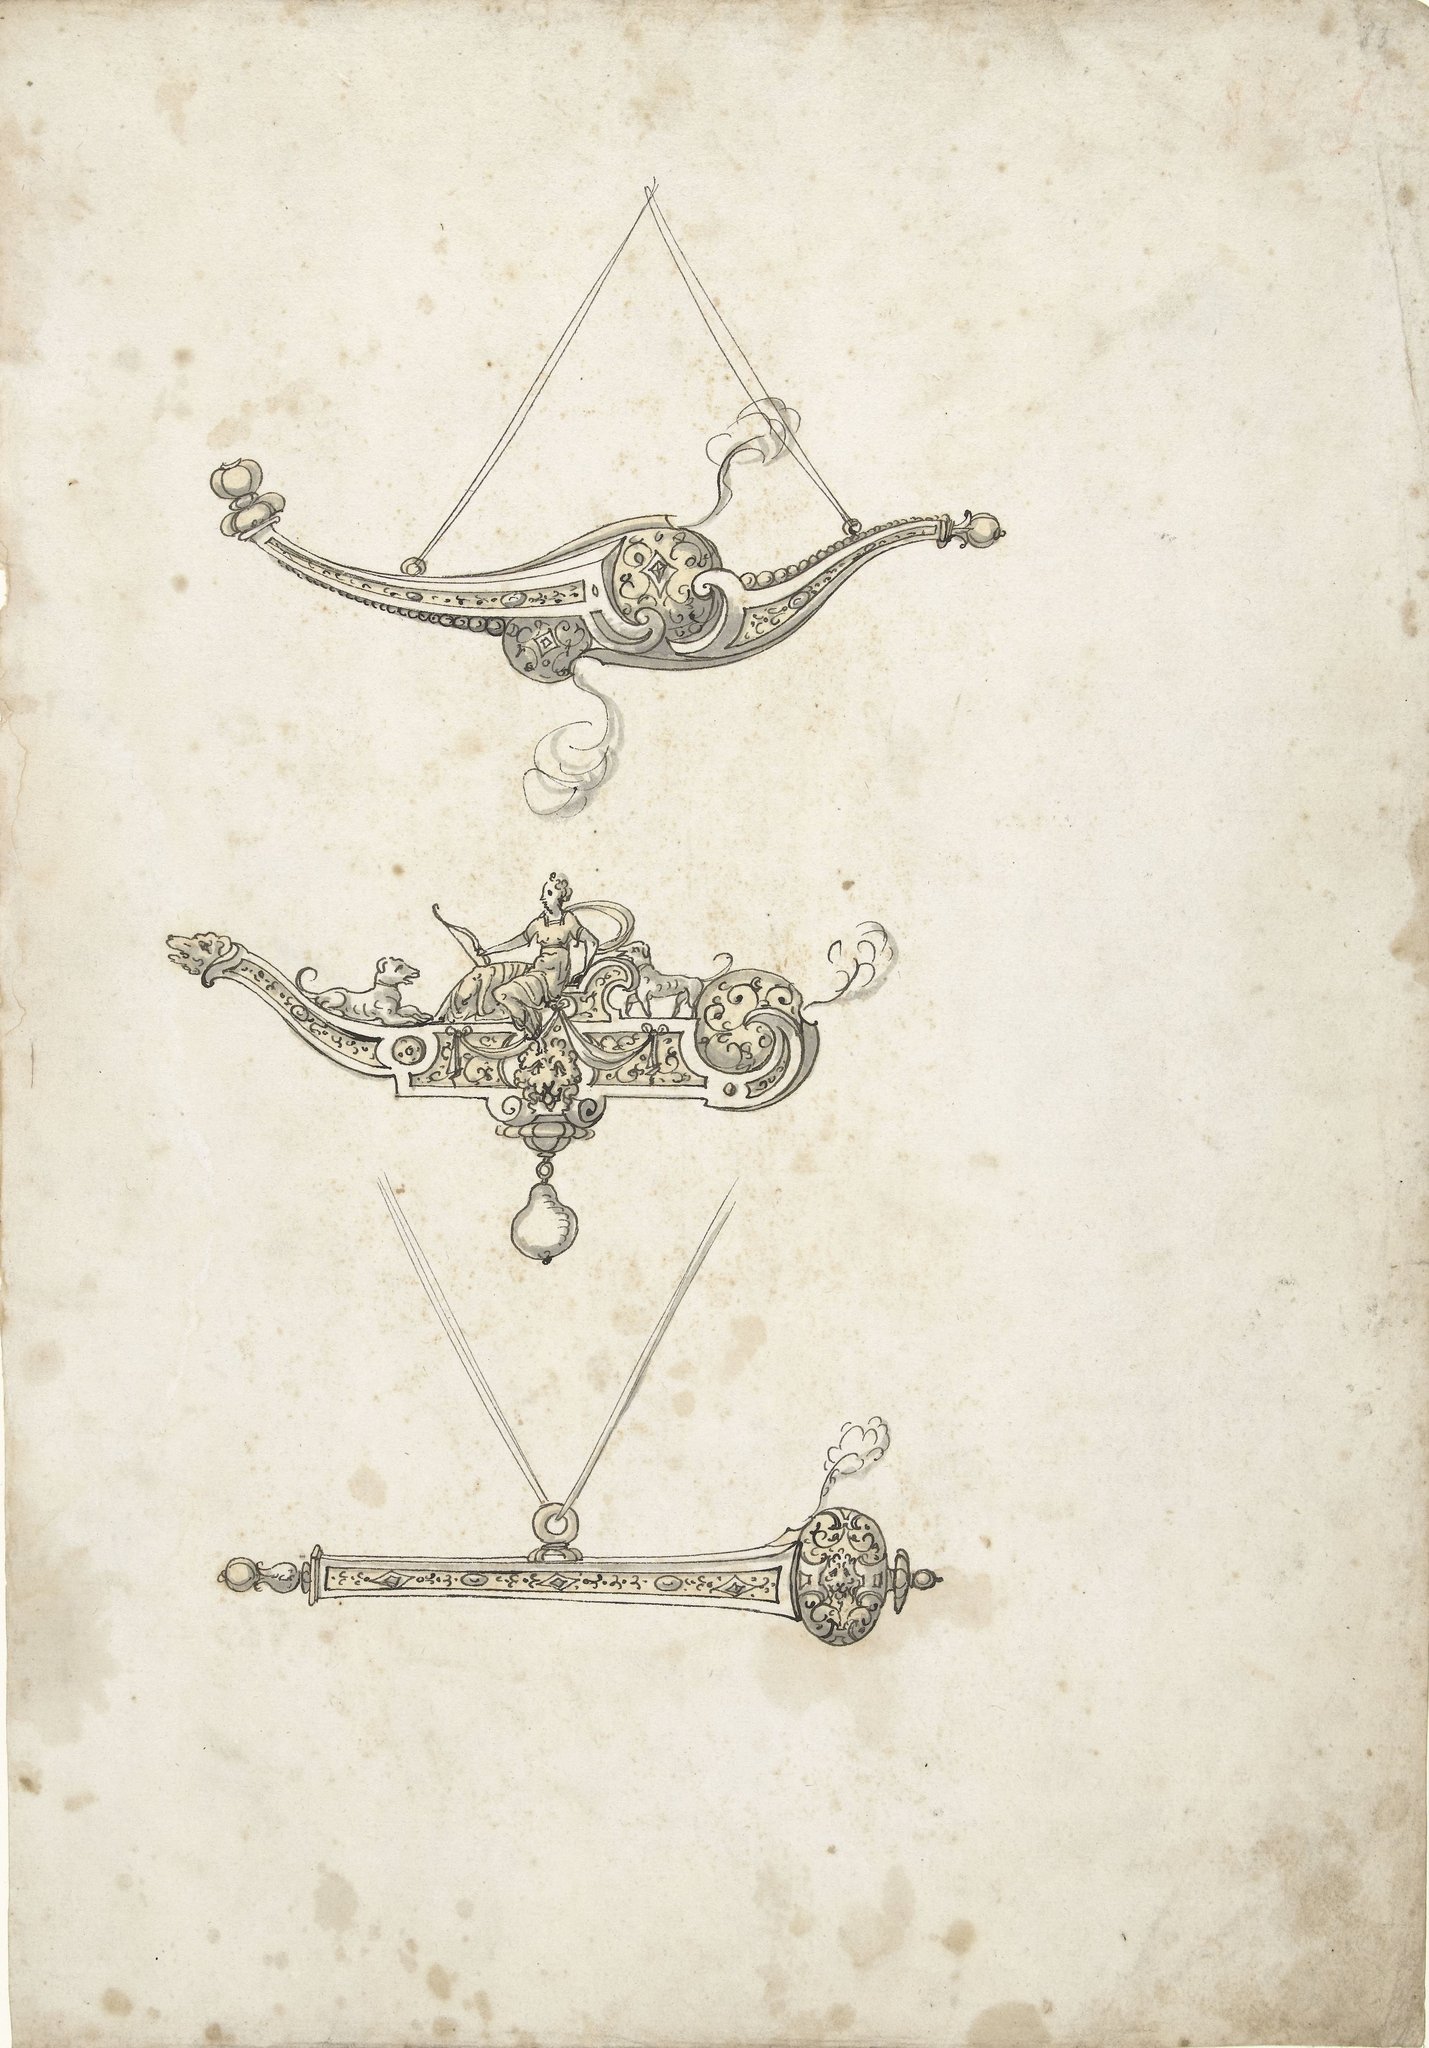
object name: drawing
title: Drie ontwerpen voor hangers in de vorm van pijpjes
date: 1560-1570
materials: ink, paper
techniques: brush, pen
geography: augsburg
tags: ornaments, jewels, pomander, musk ball